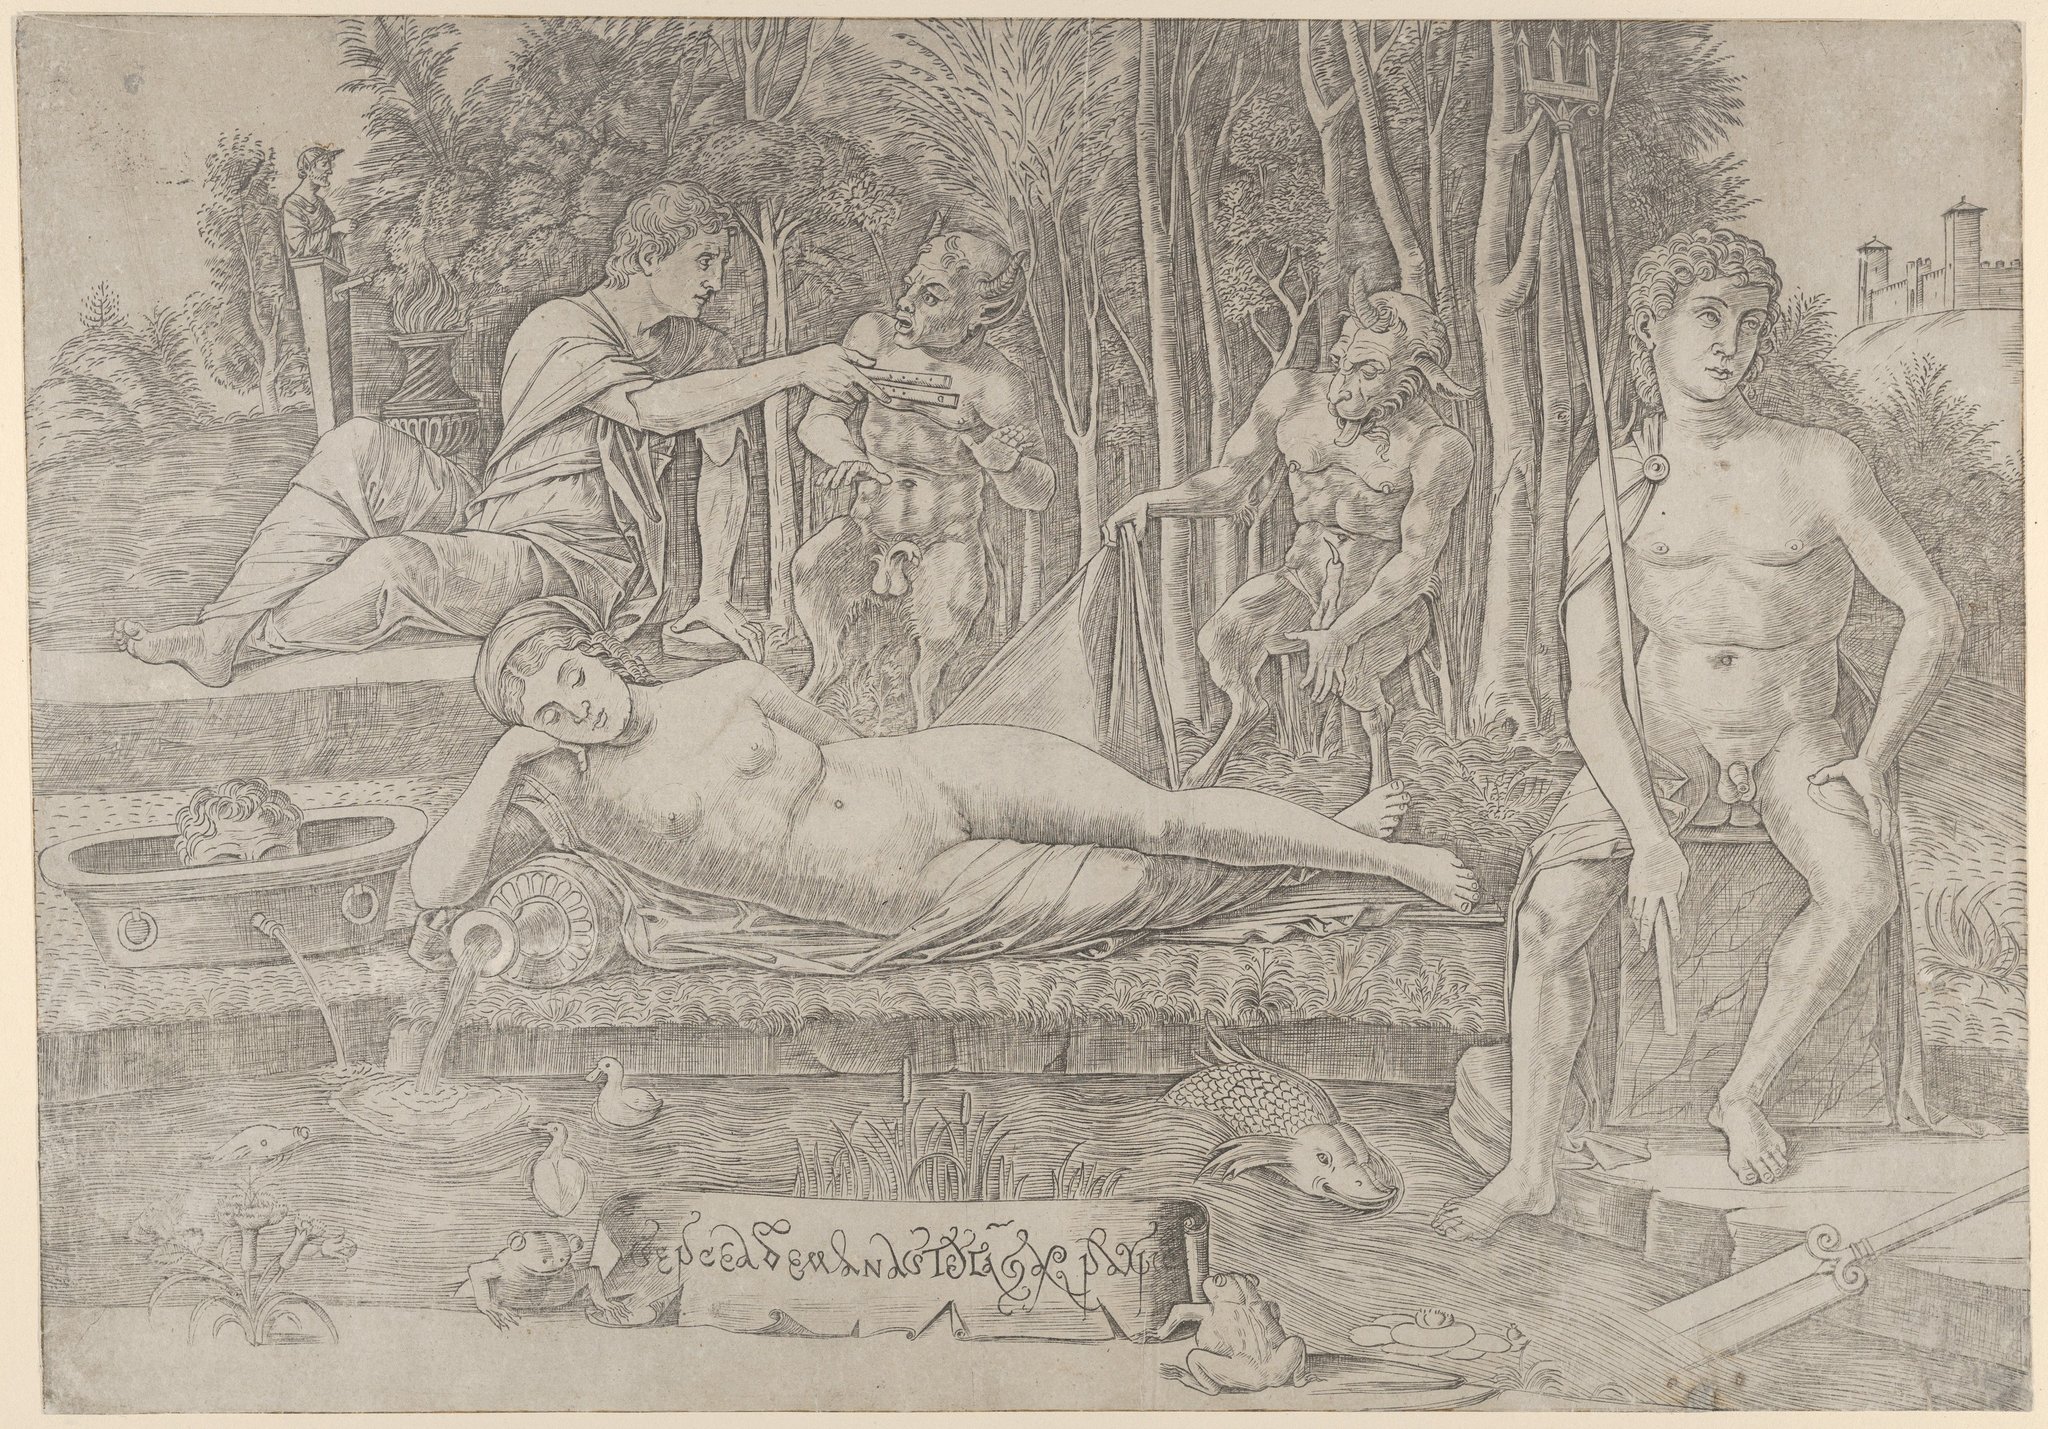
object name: print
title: The metamorphosis of Amymone who lies at center leaning on her arm, surrounded by Apollo at left, Neptune at right and two satyrs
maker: girolamo mocetto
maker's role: artist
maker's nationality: italian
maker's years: 1470-1531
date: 1490-1530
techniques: engraving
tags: apollo,neptune,satyrs